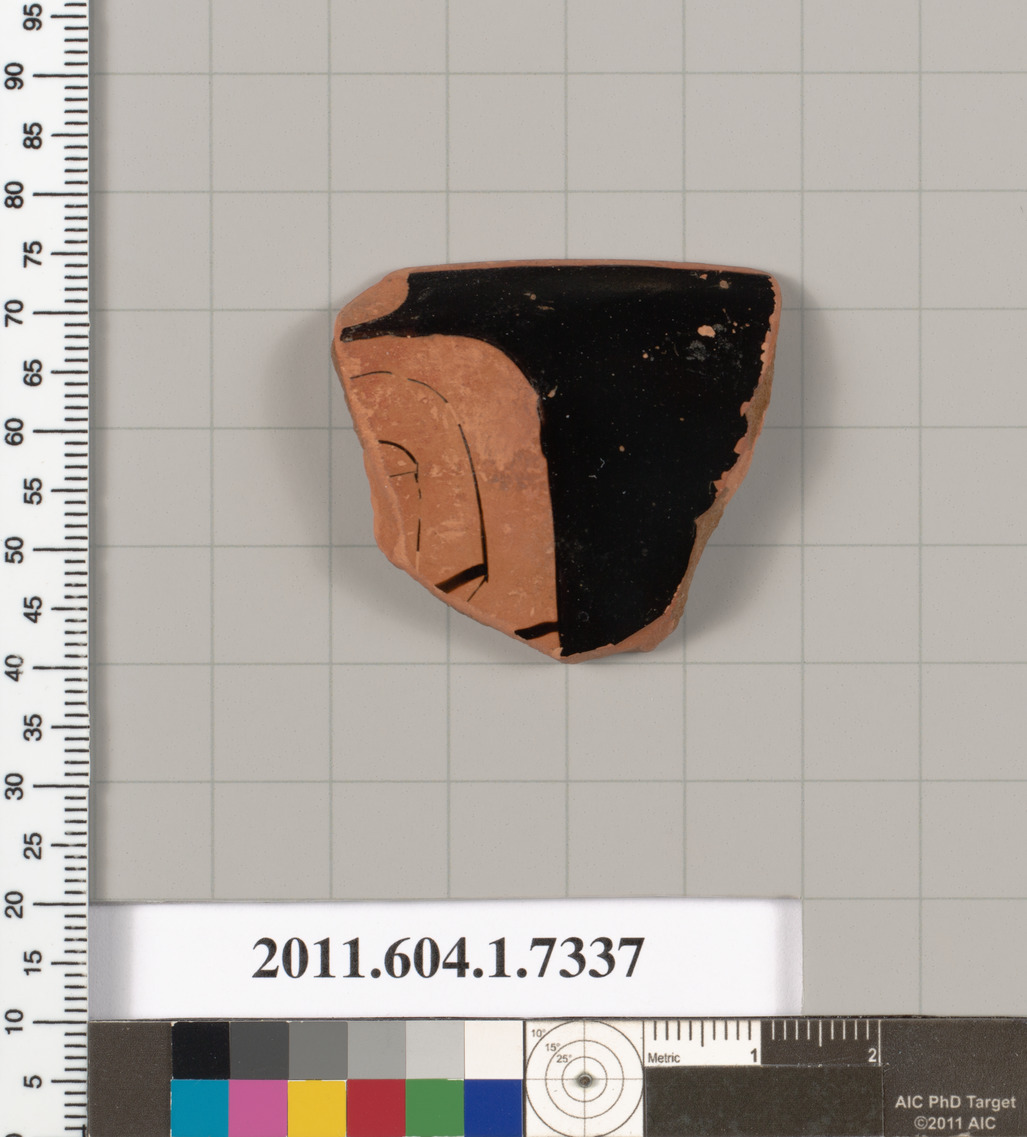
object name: kylix fragment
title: Terracotta rim fragment of a kylix (drinking cup)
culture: greek, attic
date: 500-480 BCE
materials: terracotta